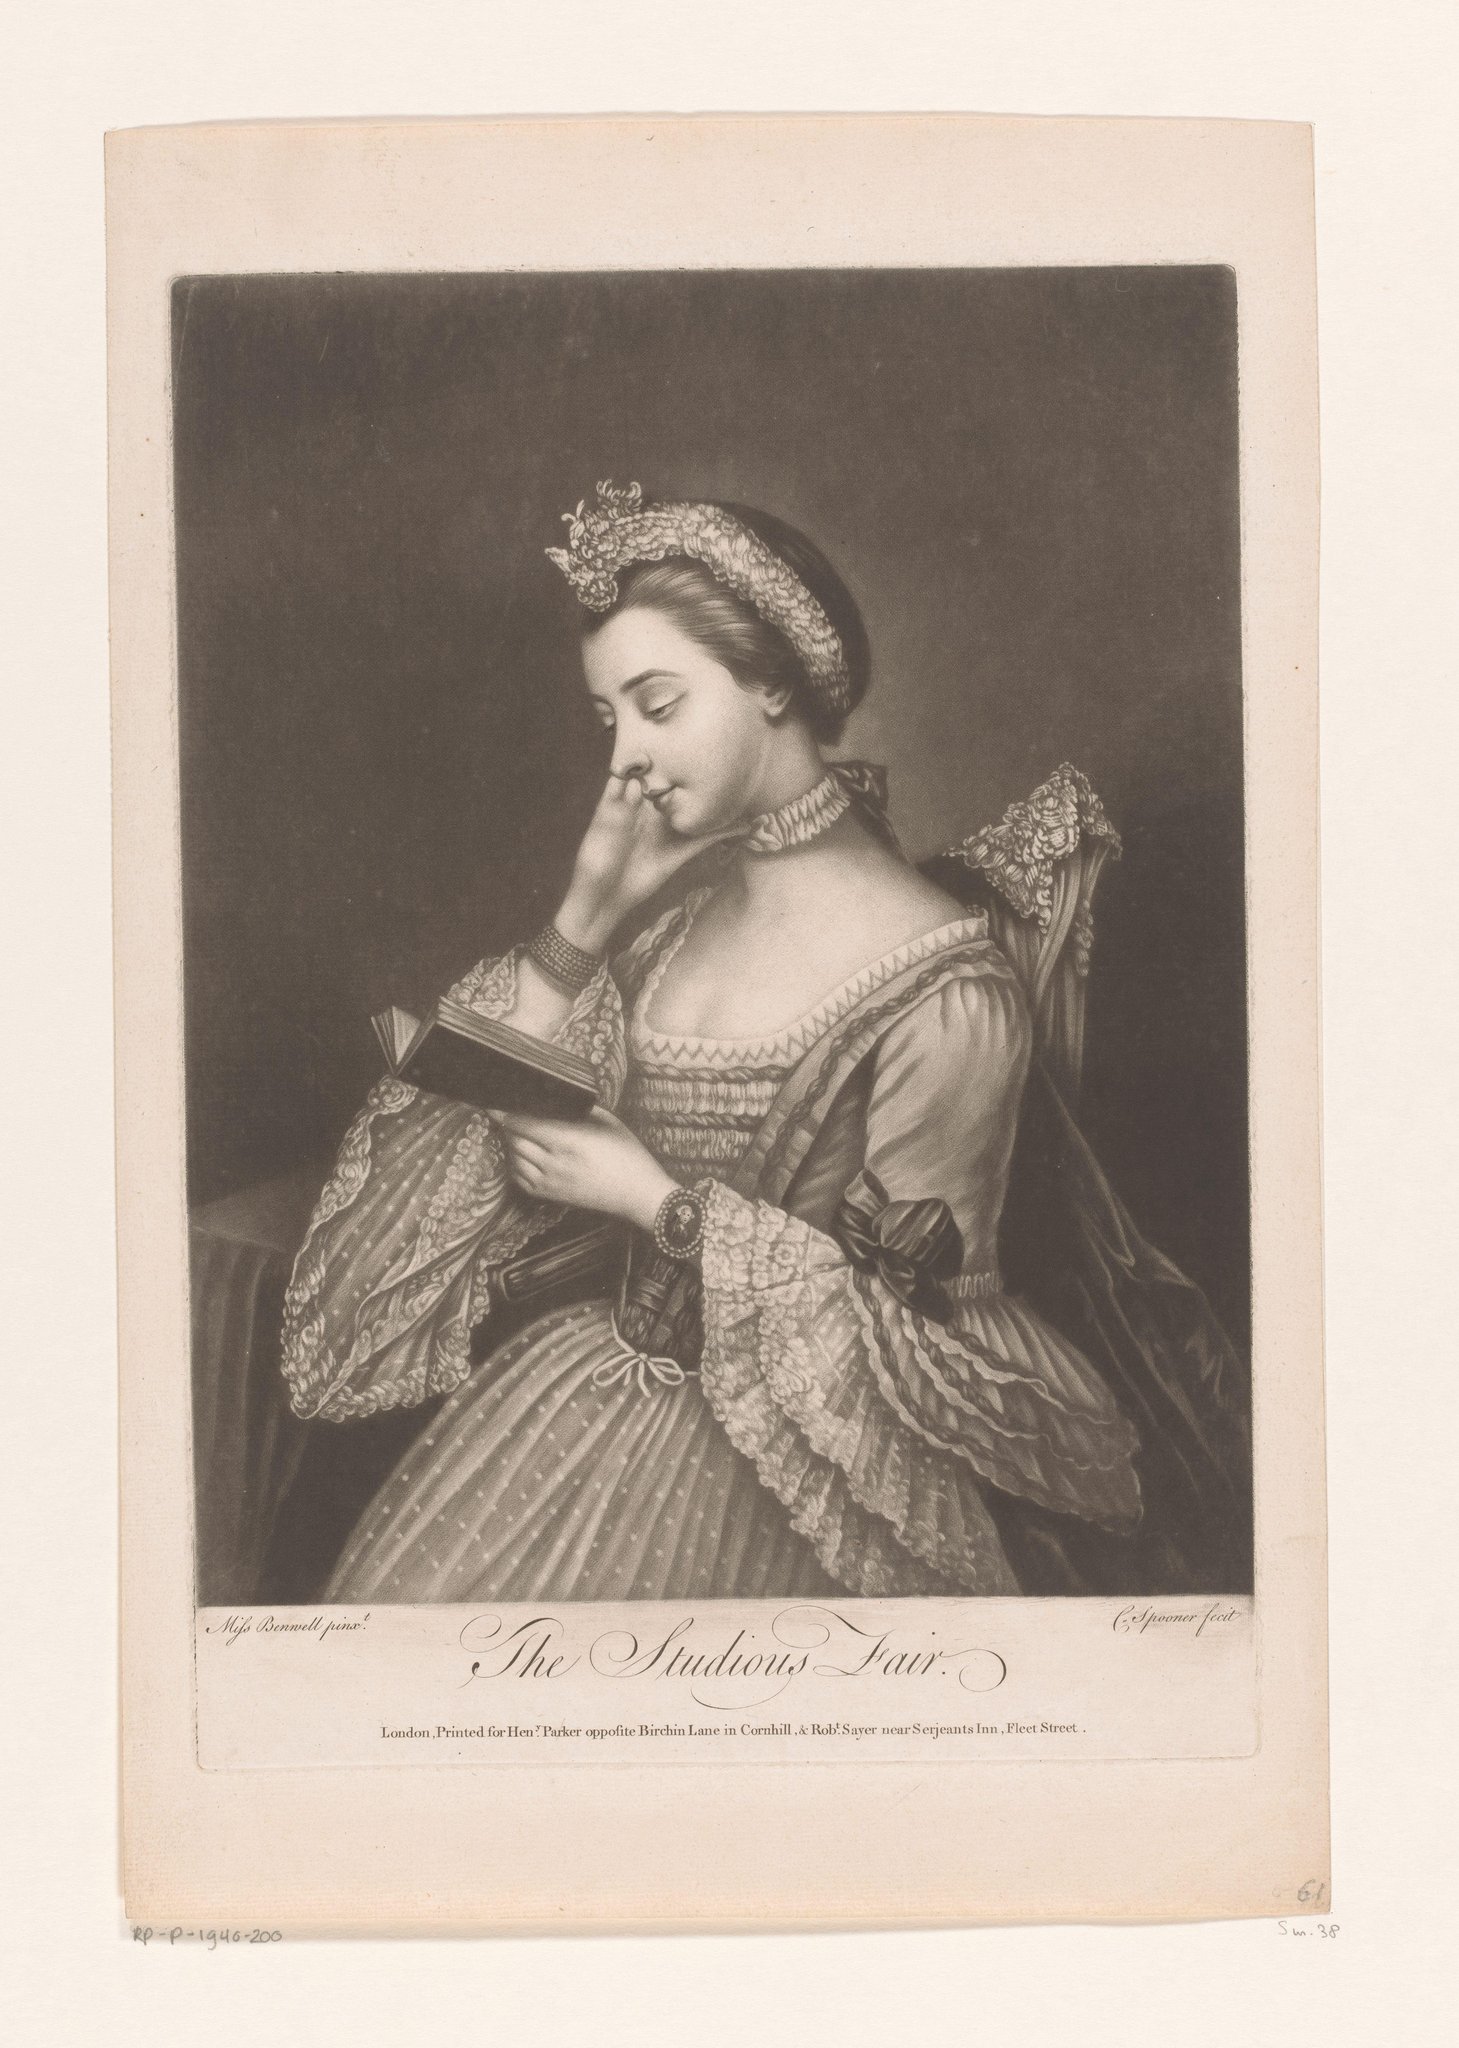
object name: print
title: Lezende vrouw aan een tafel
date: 1748-1767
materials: paper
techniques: mezzotint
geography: london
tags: reading, lace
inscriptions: collector's mark: Lugt 2228